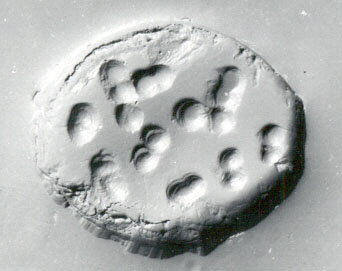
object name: stamp seal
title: Drilled half almond seal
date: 3500-2900 BCE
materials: alabaster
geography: mesopotamia or southwestern iran